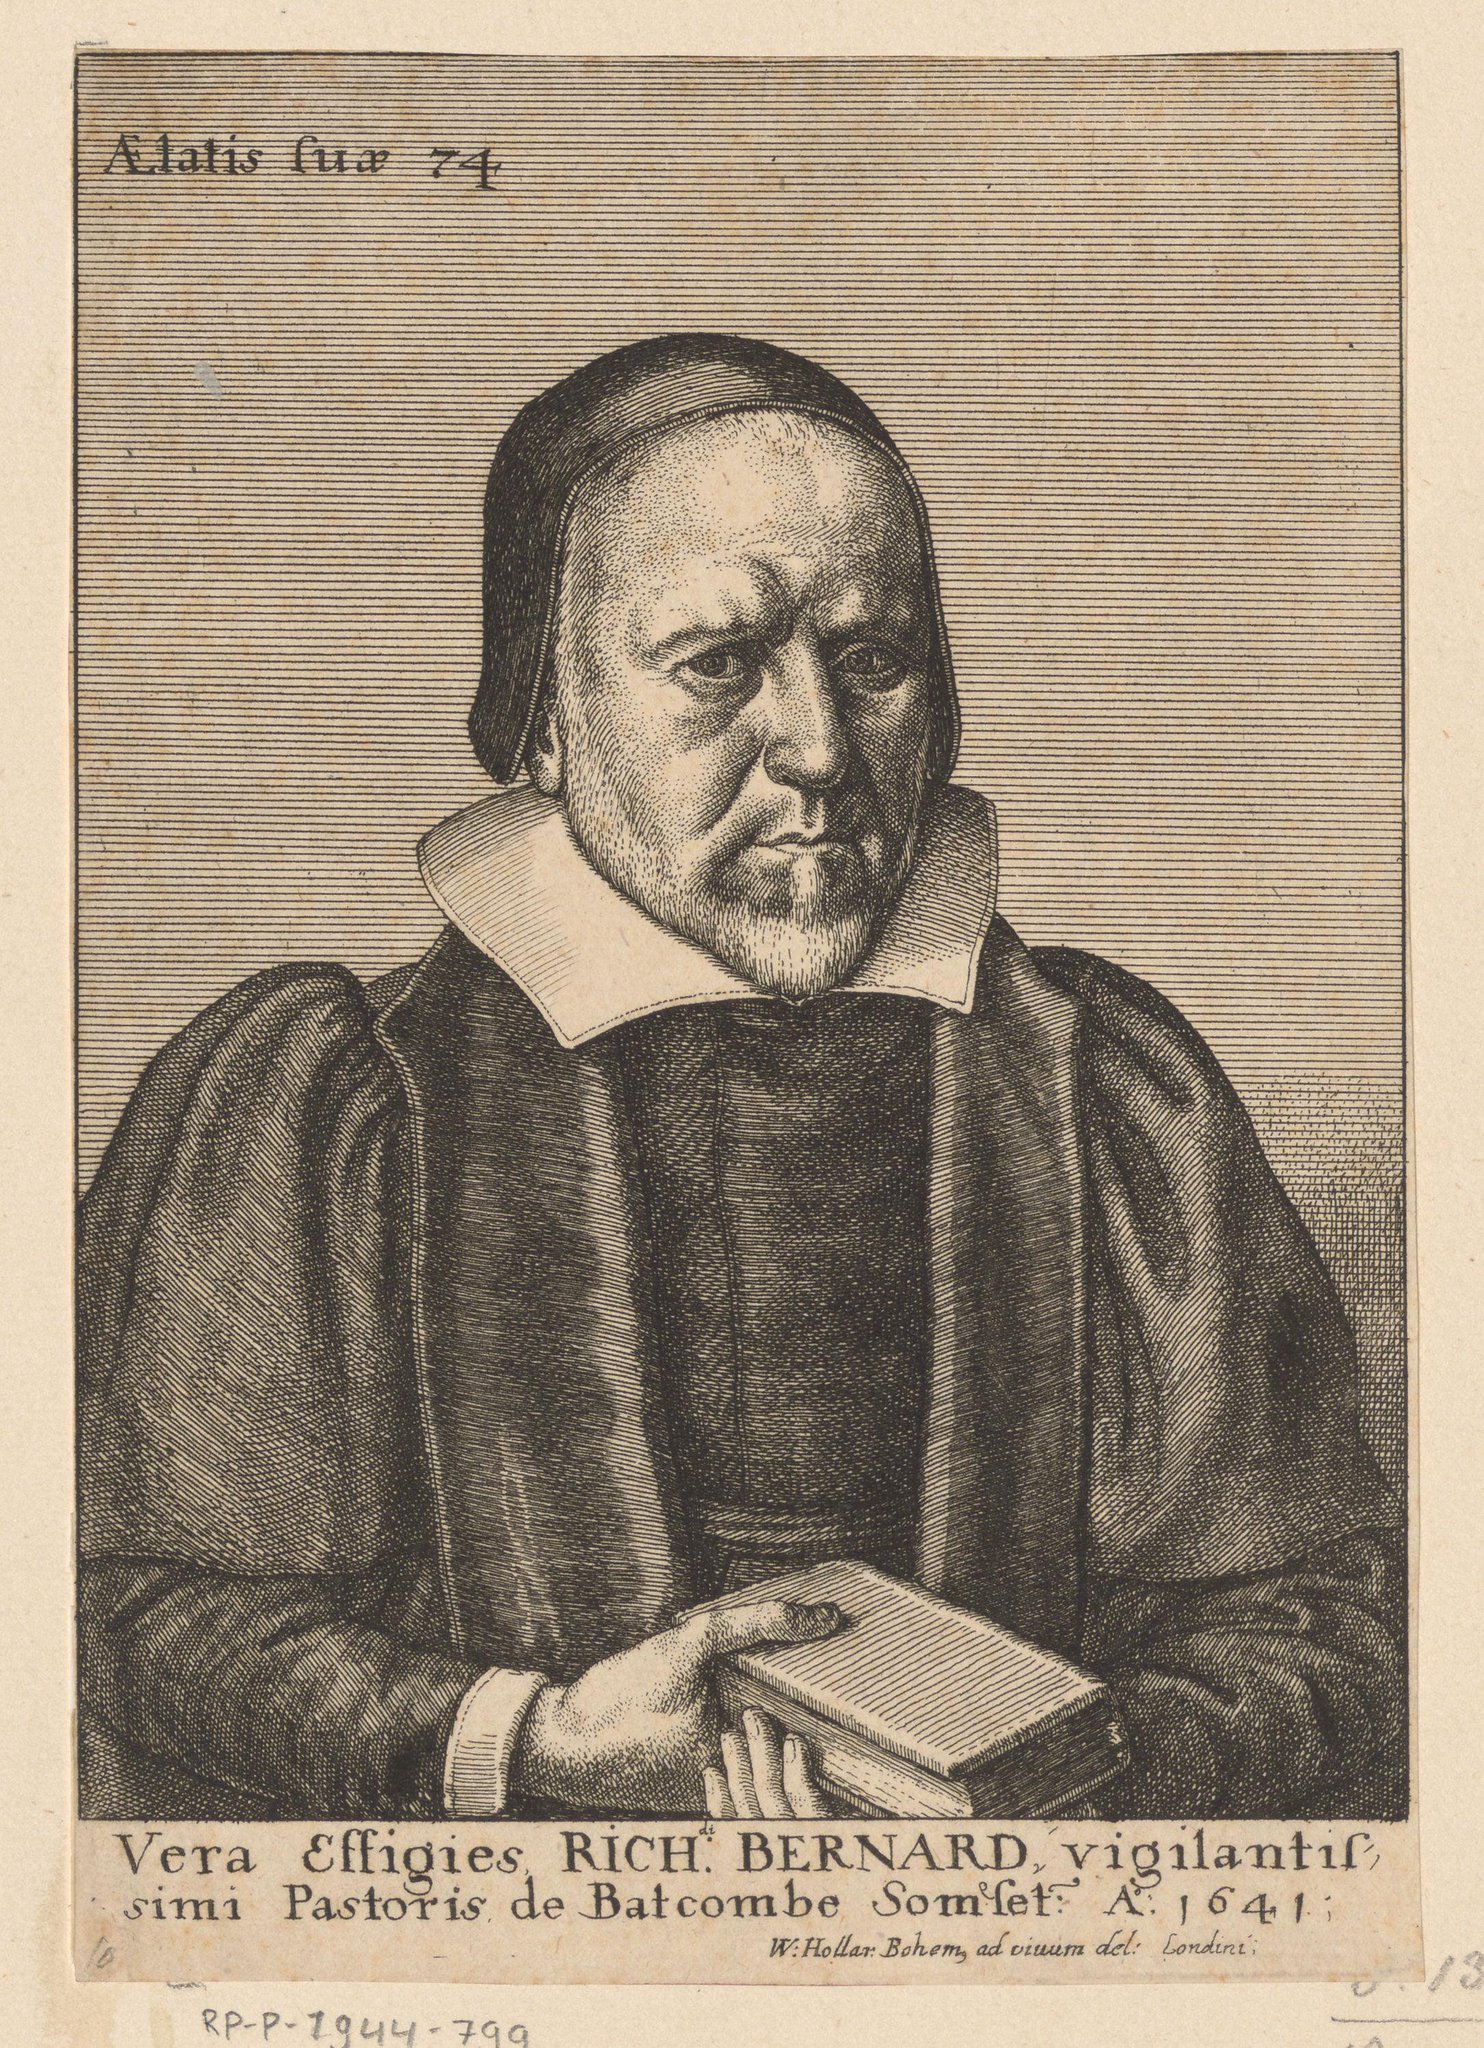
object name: print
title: Portret van Richard Bernard op 74-jarige leeftijd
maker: wenceslaus hollar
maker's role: draughtsman, print maker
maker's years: 1607-1677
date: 1641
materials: paper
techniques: etching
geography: london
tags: historical persons, portrait of a writer, book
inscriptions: collector's mark: Lugt 2228